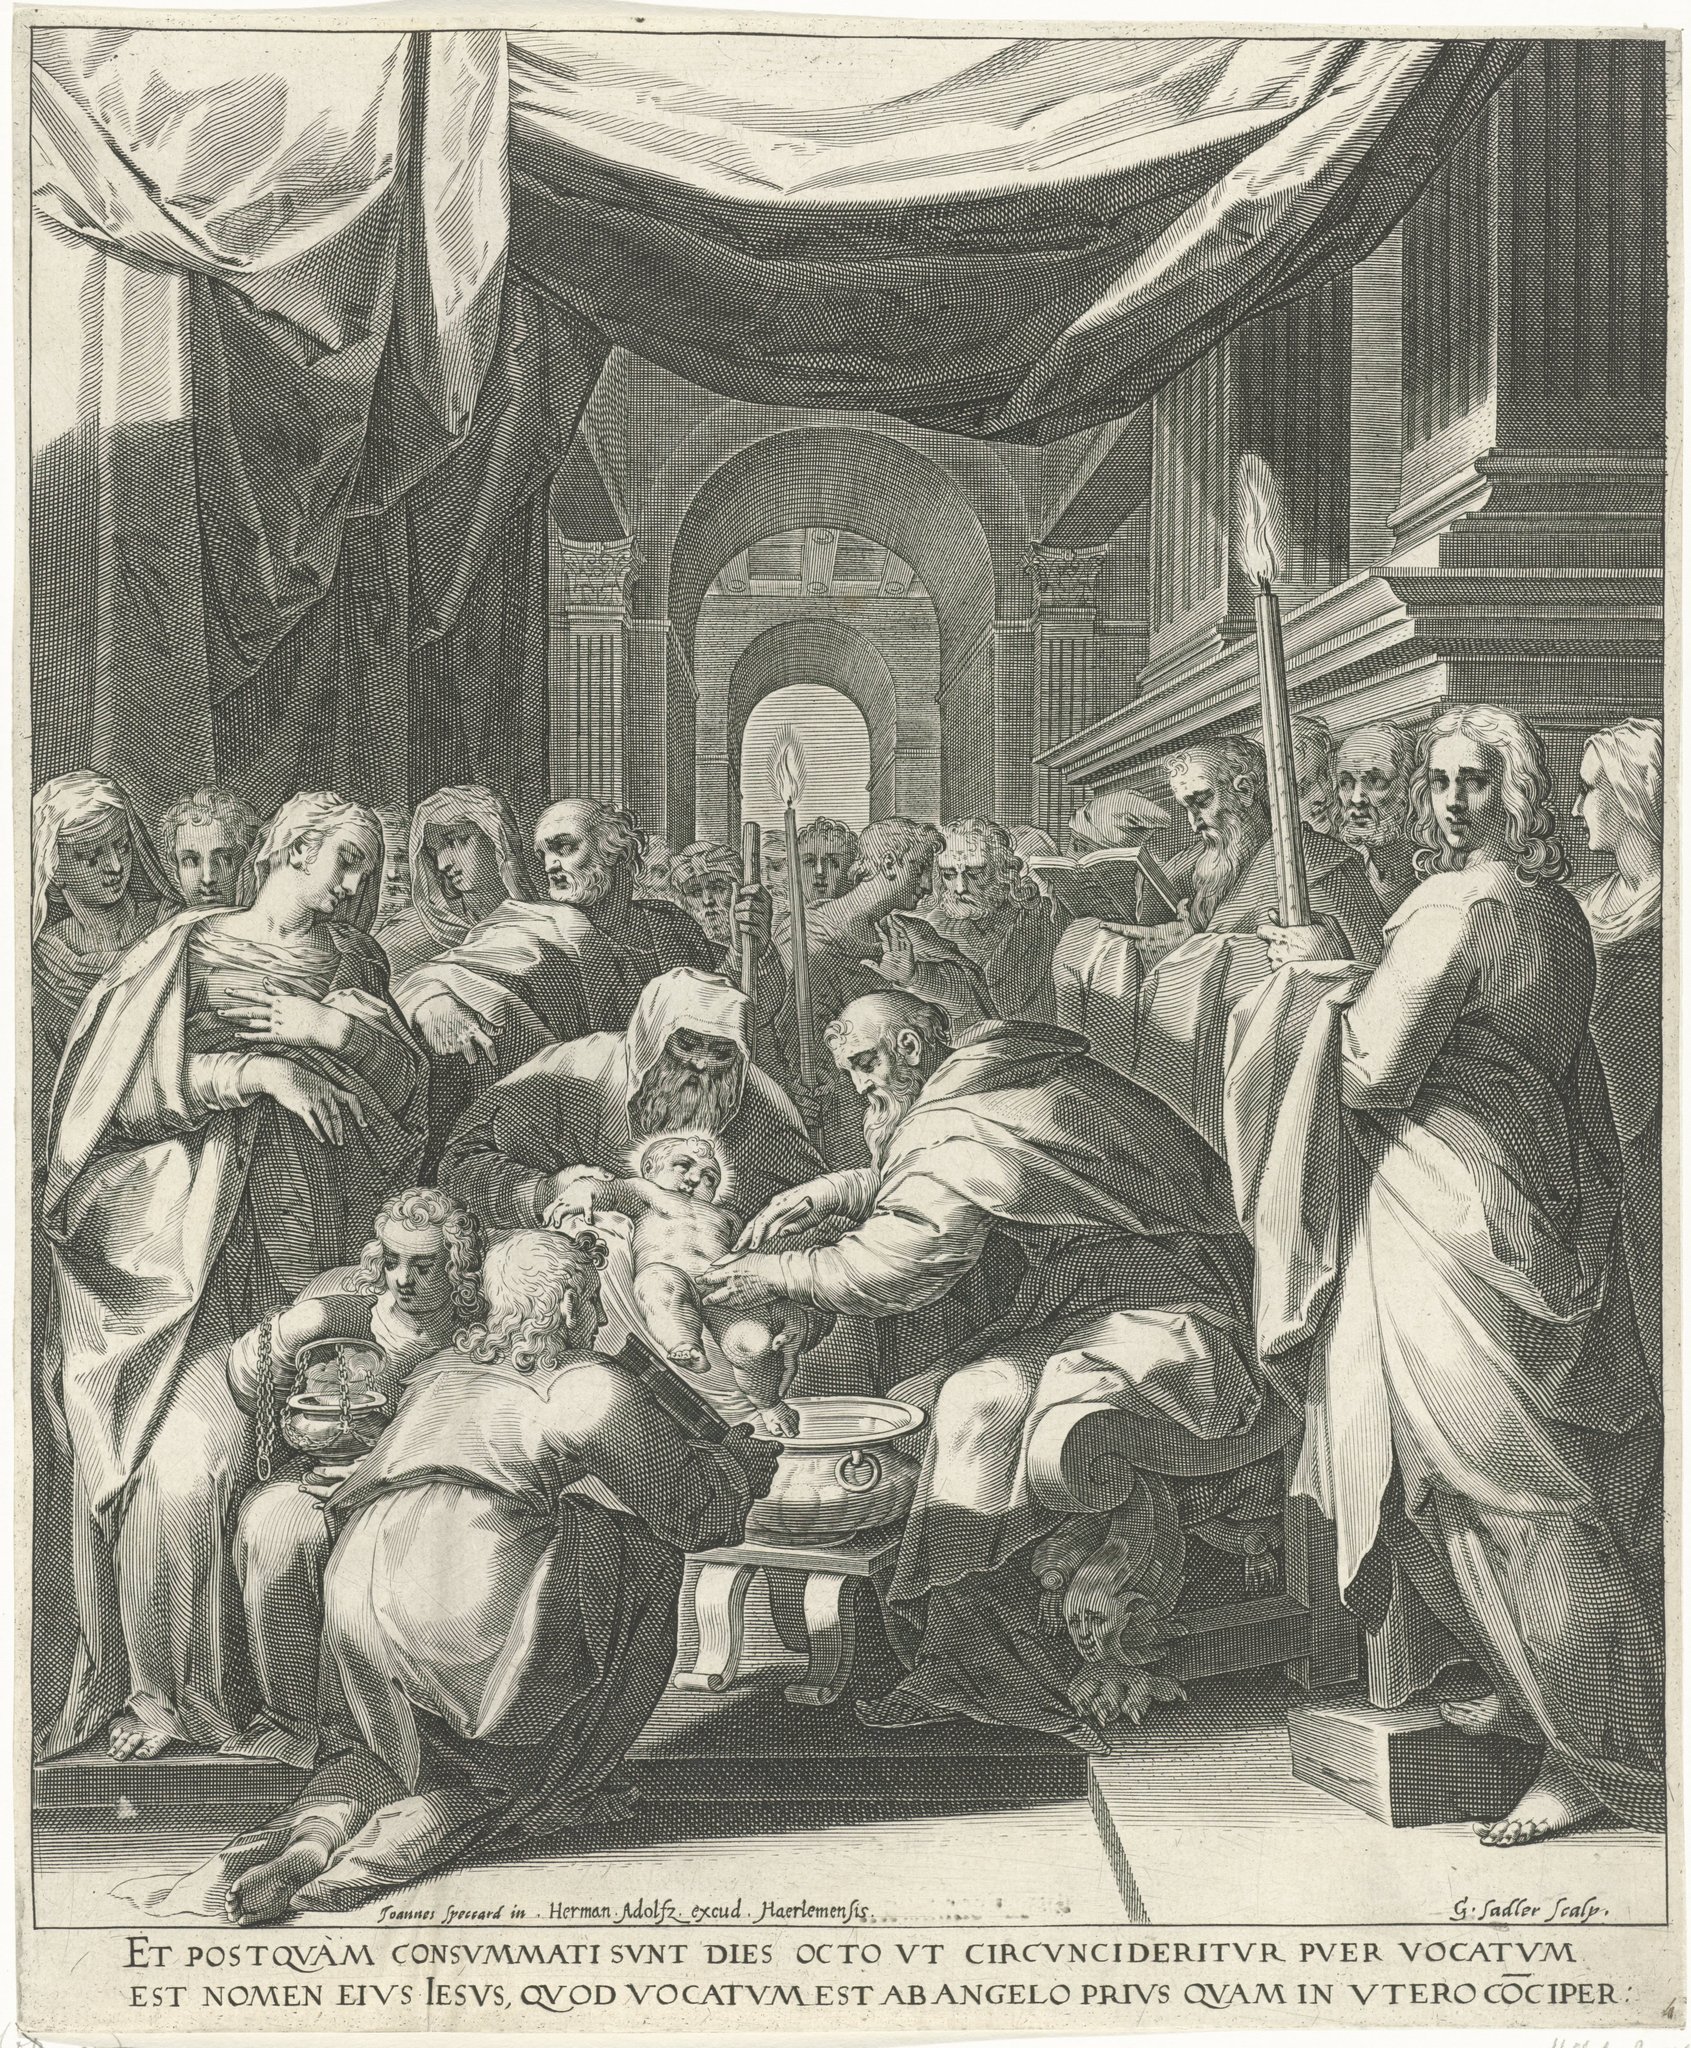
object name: print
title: Besnijdenis van Christus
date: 1607-1629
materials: paper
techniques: engraving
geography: haarlem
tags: circumcision of the christ-child by mary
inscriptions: collector's mark: Lugt 11, number: ‘4’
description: De hogepriester besnijdt het Christuskind. Maria en Jozef kijken samen met anderen toe. De prent heeft een Latijns onderschrift.